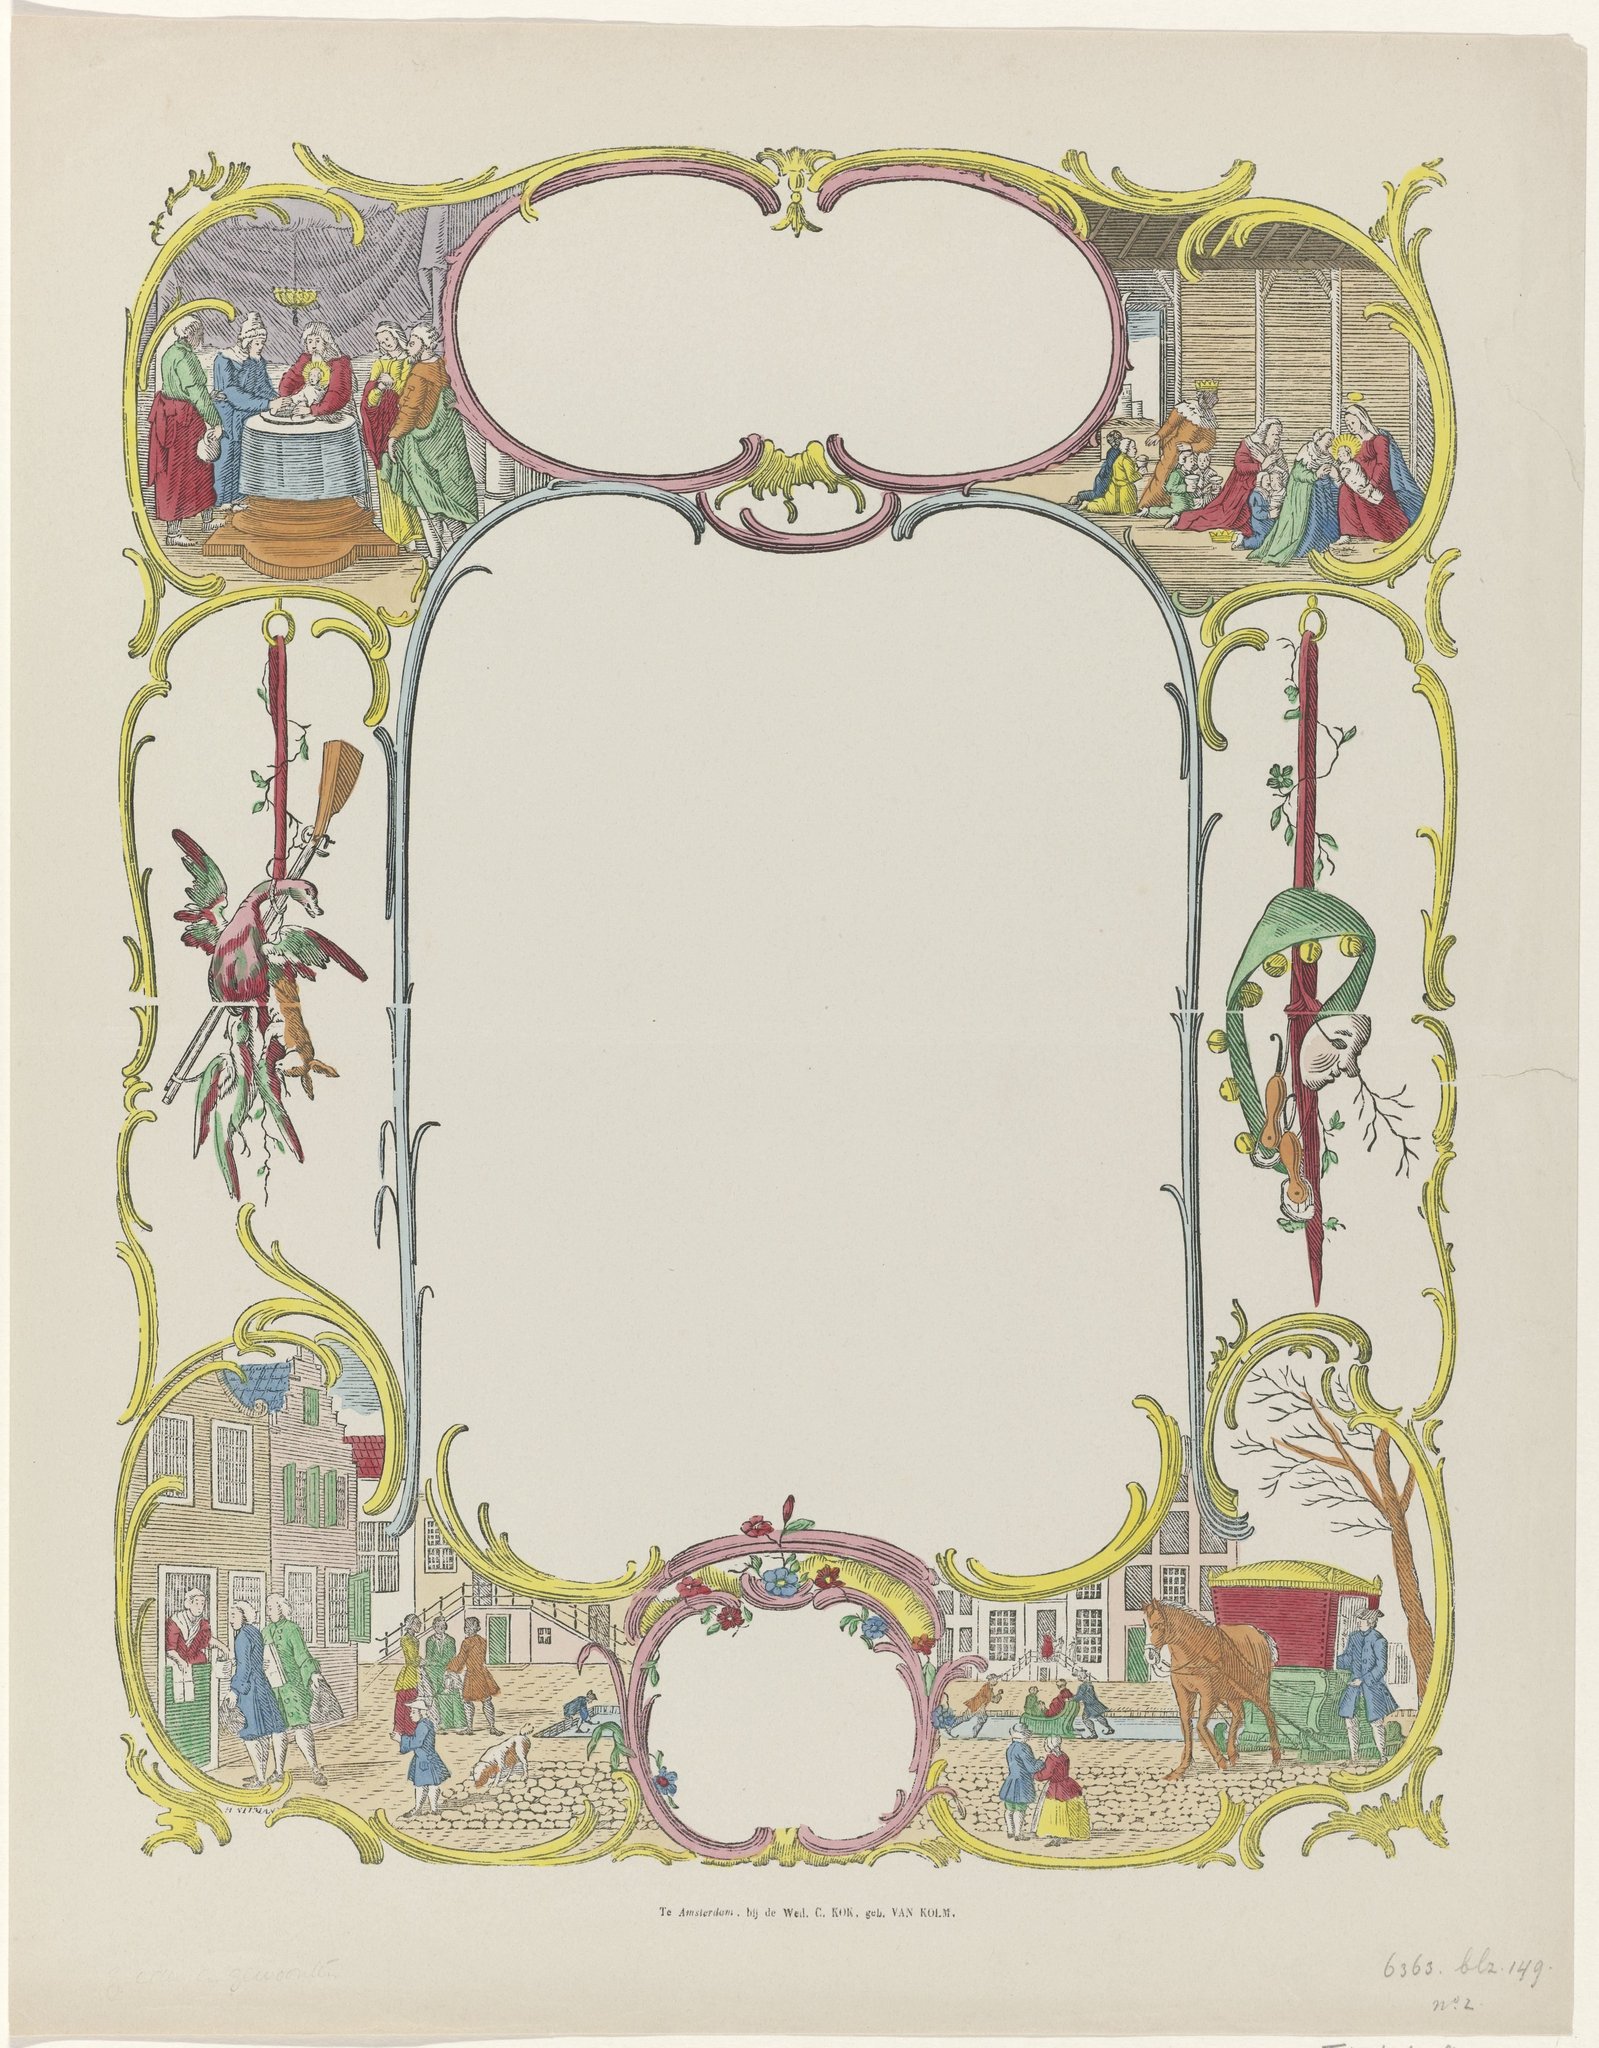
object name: print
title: Wensbrief met decoratief kader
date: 1775-1780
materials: paper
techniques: hand coloring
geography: netherlands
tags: skates (winter sports), birth and youth of christ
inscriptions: collector's mark: Lugt 2228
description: Wensbrief met onbeschreven cartouche binnen een decoratief kader met boven twee voorstellingen uit het leven van Christus en onder twee straatgezichten met wintervermaak. Ca. 1800-1850.